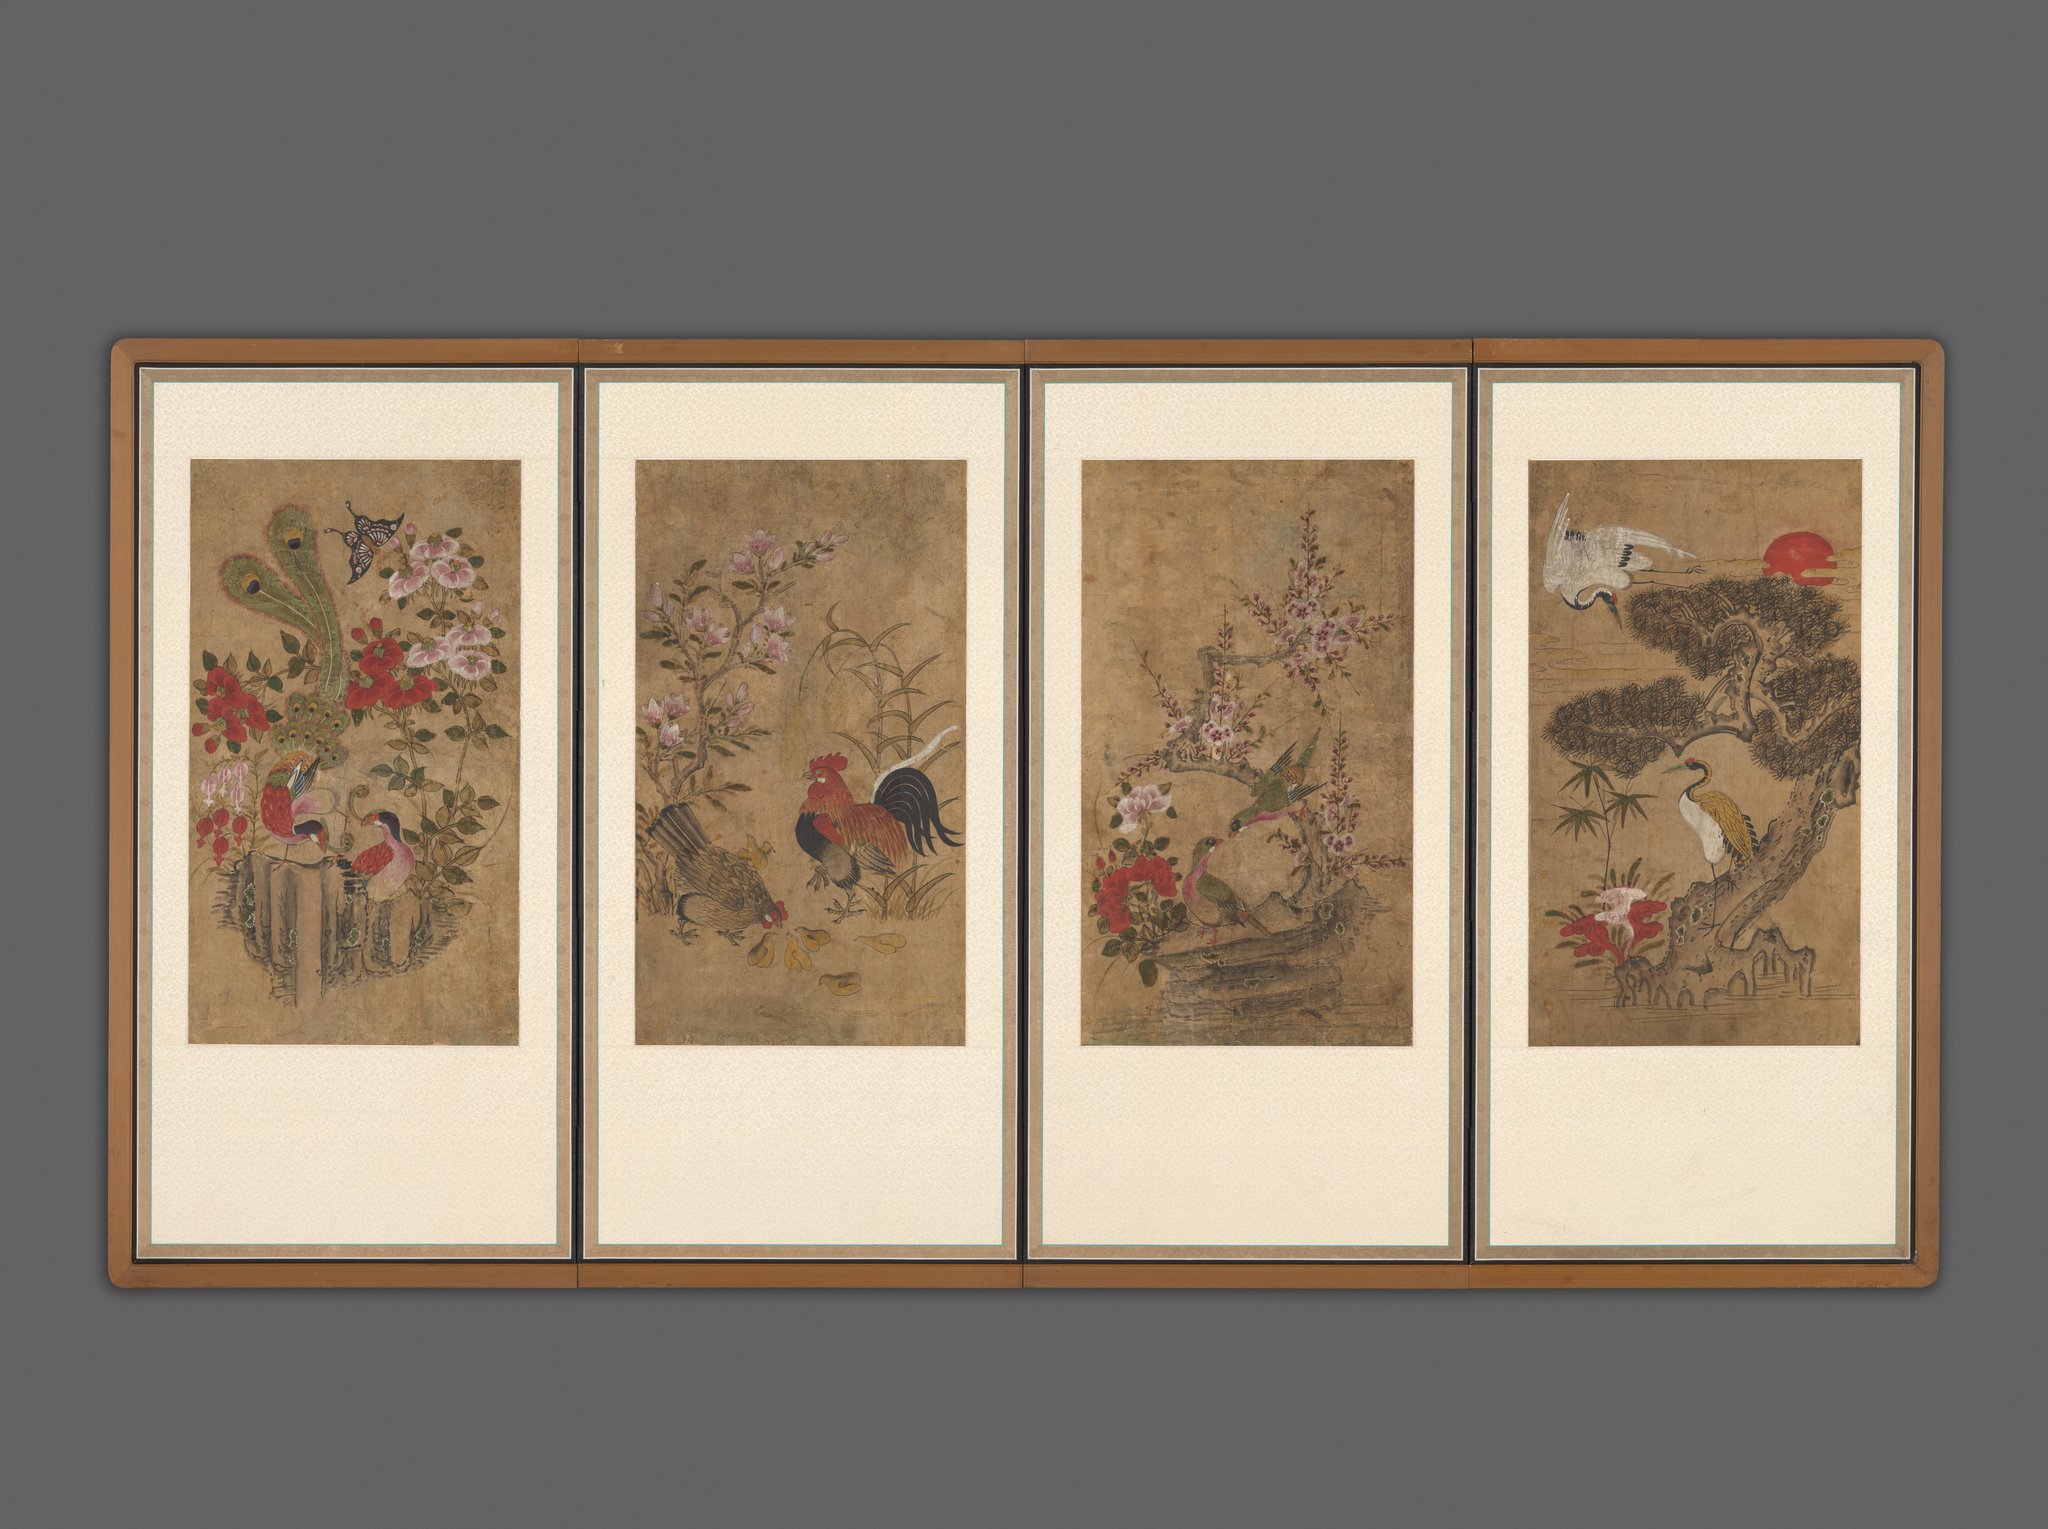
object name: screen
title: Birds and Flowers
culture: korean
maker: unidentified artist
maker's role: artist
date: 1801-1900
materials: ink, panel, paper